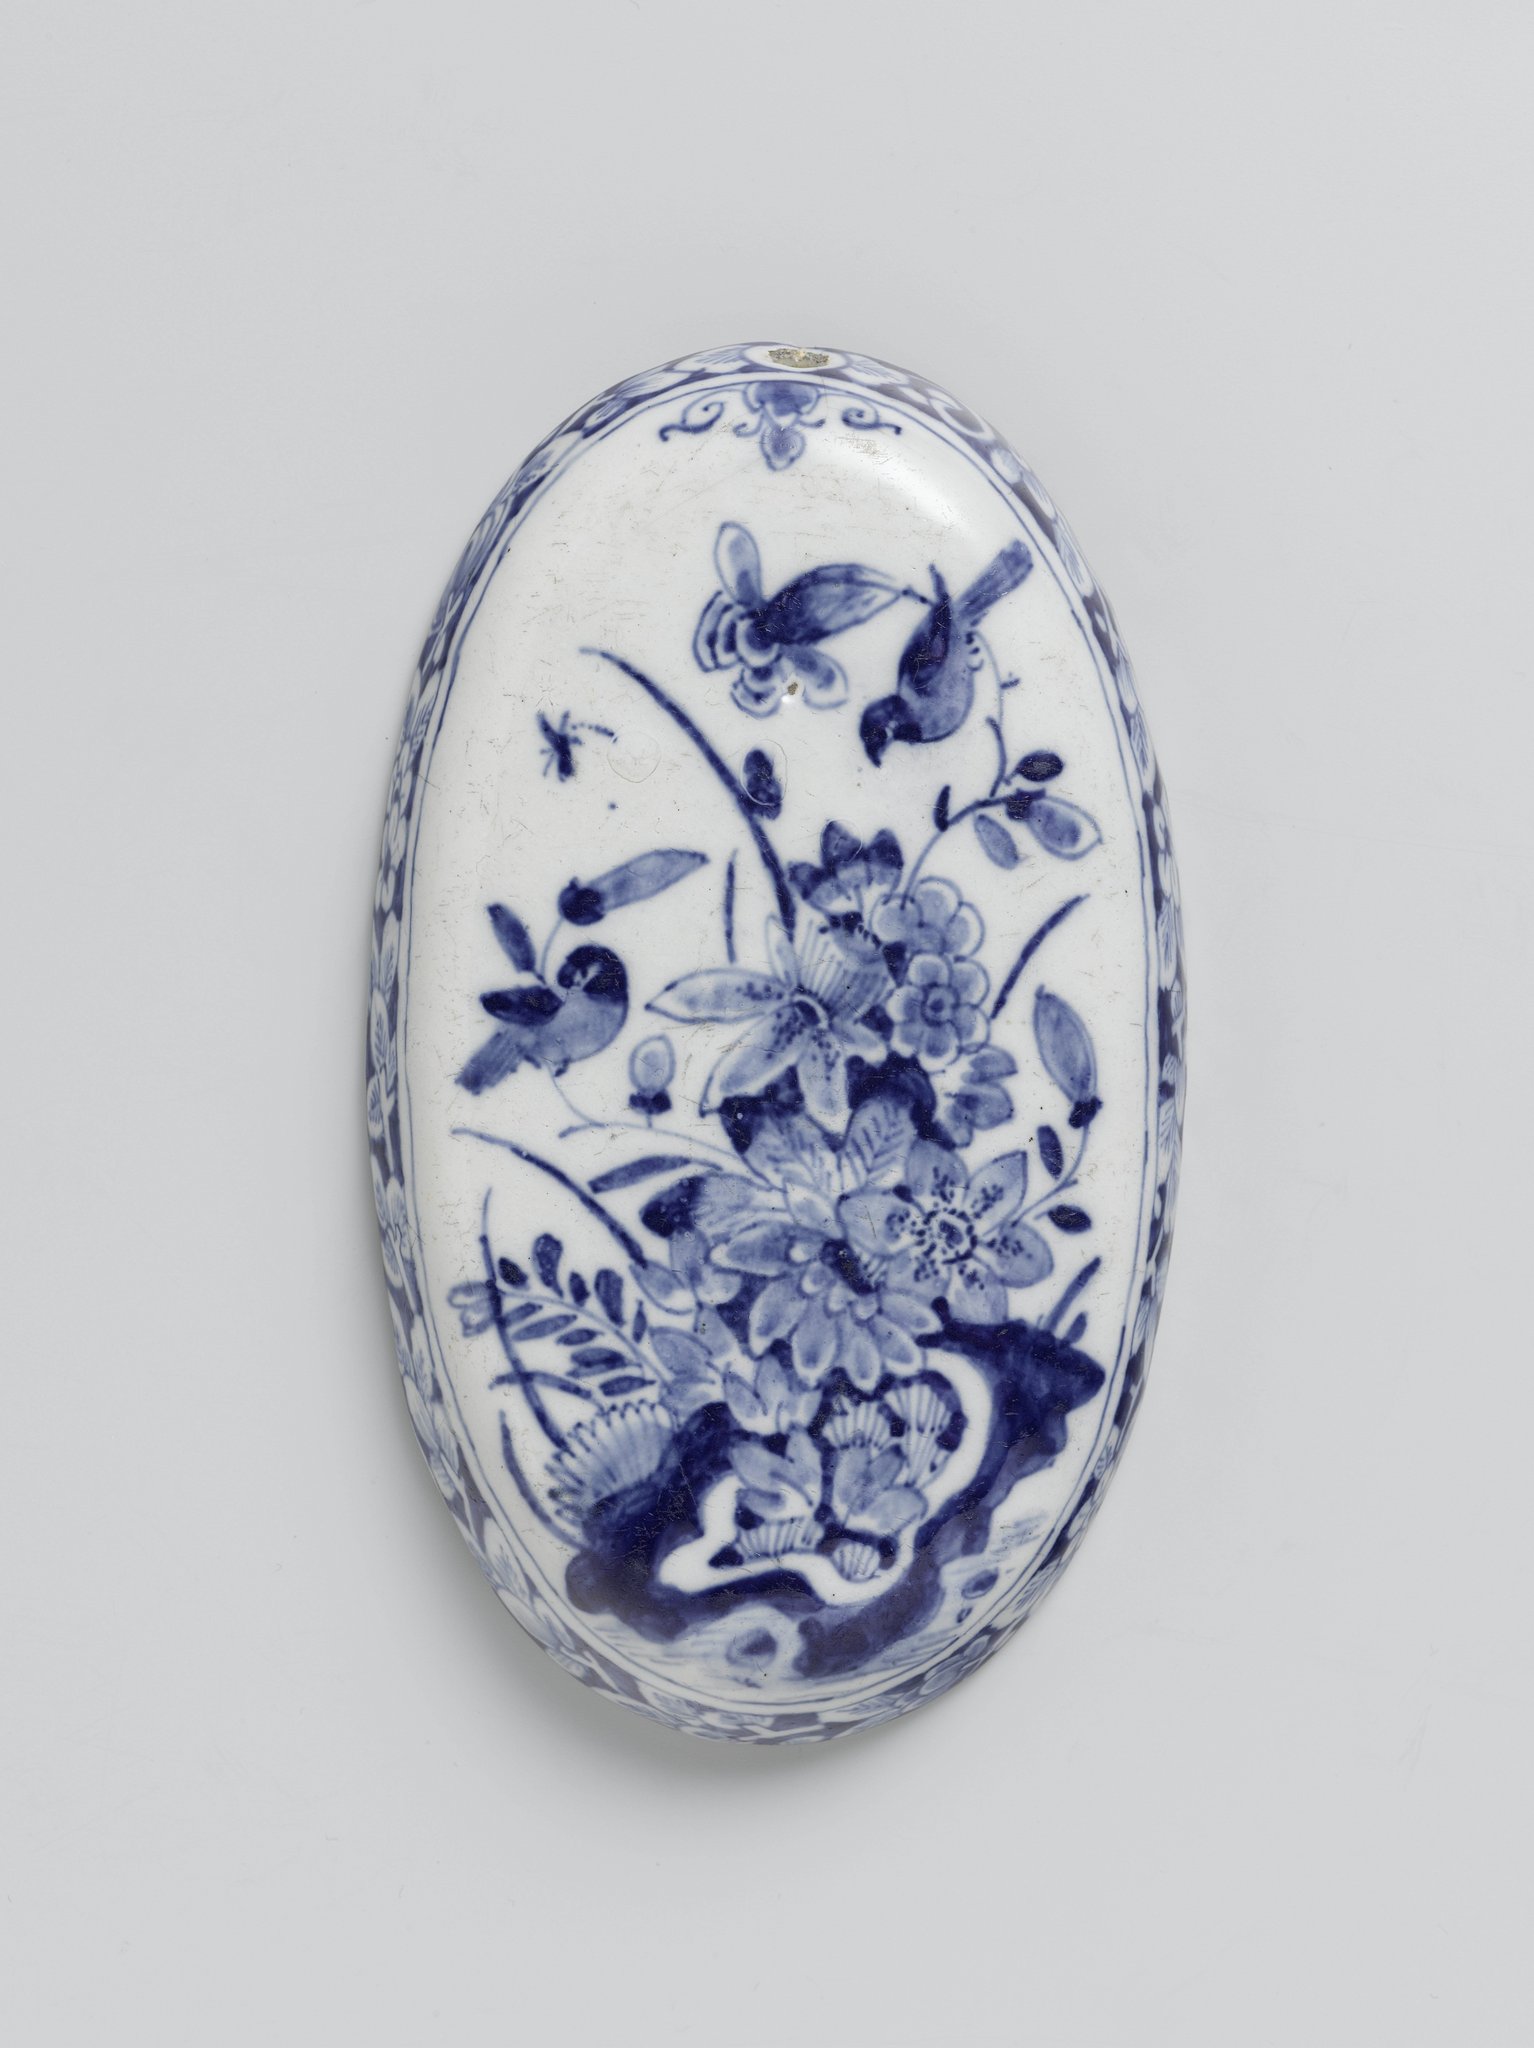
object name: borstelrug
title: Borstelrug van faïence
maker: Anonymous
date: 1725-1750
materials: faience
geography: delft